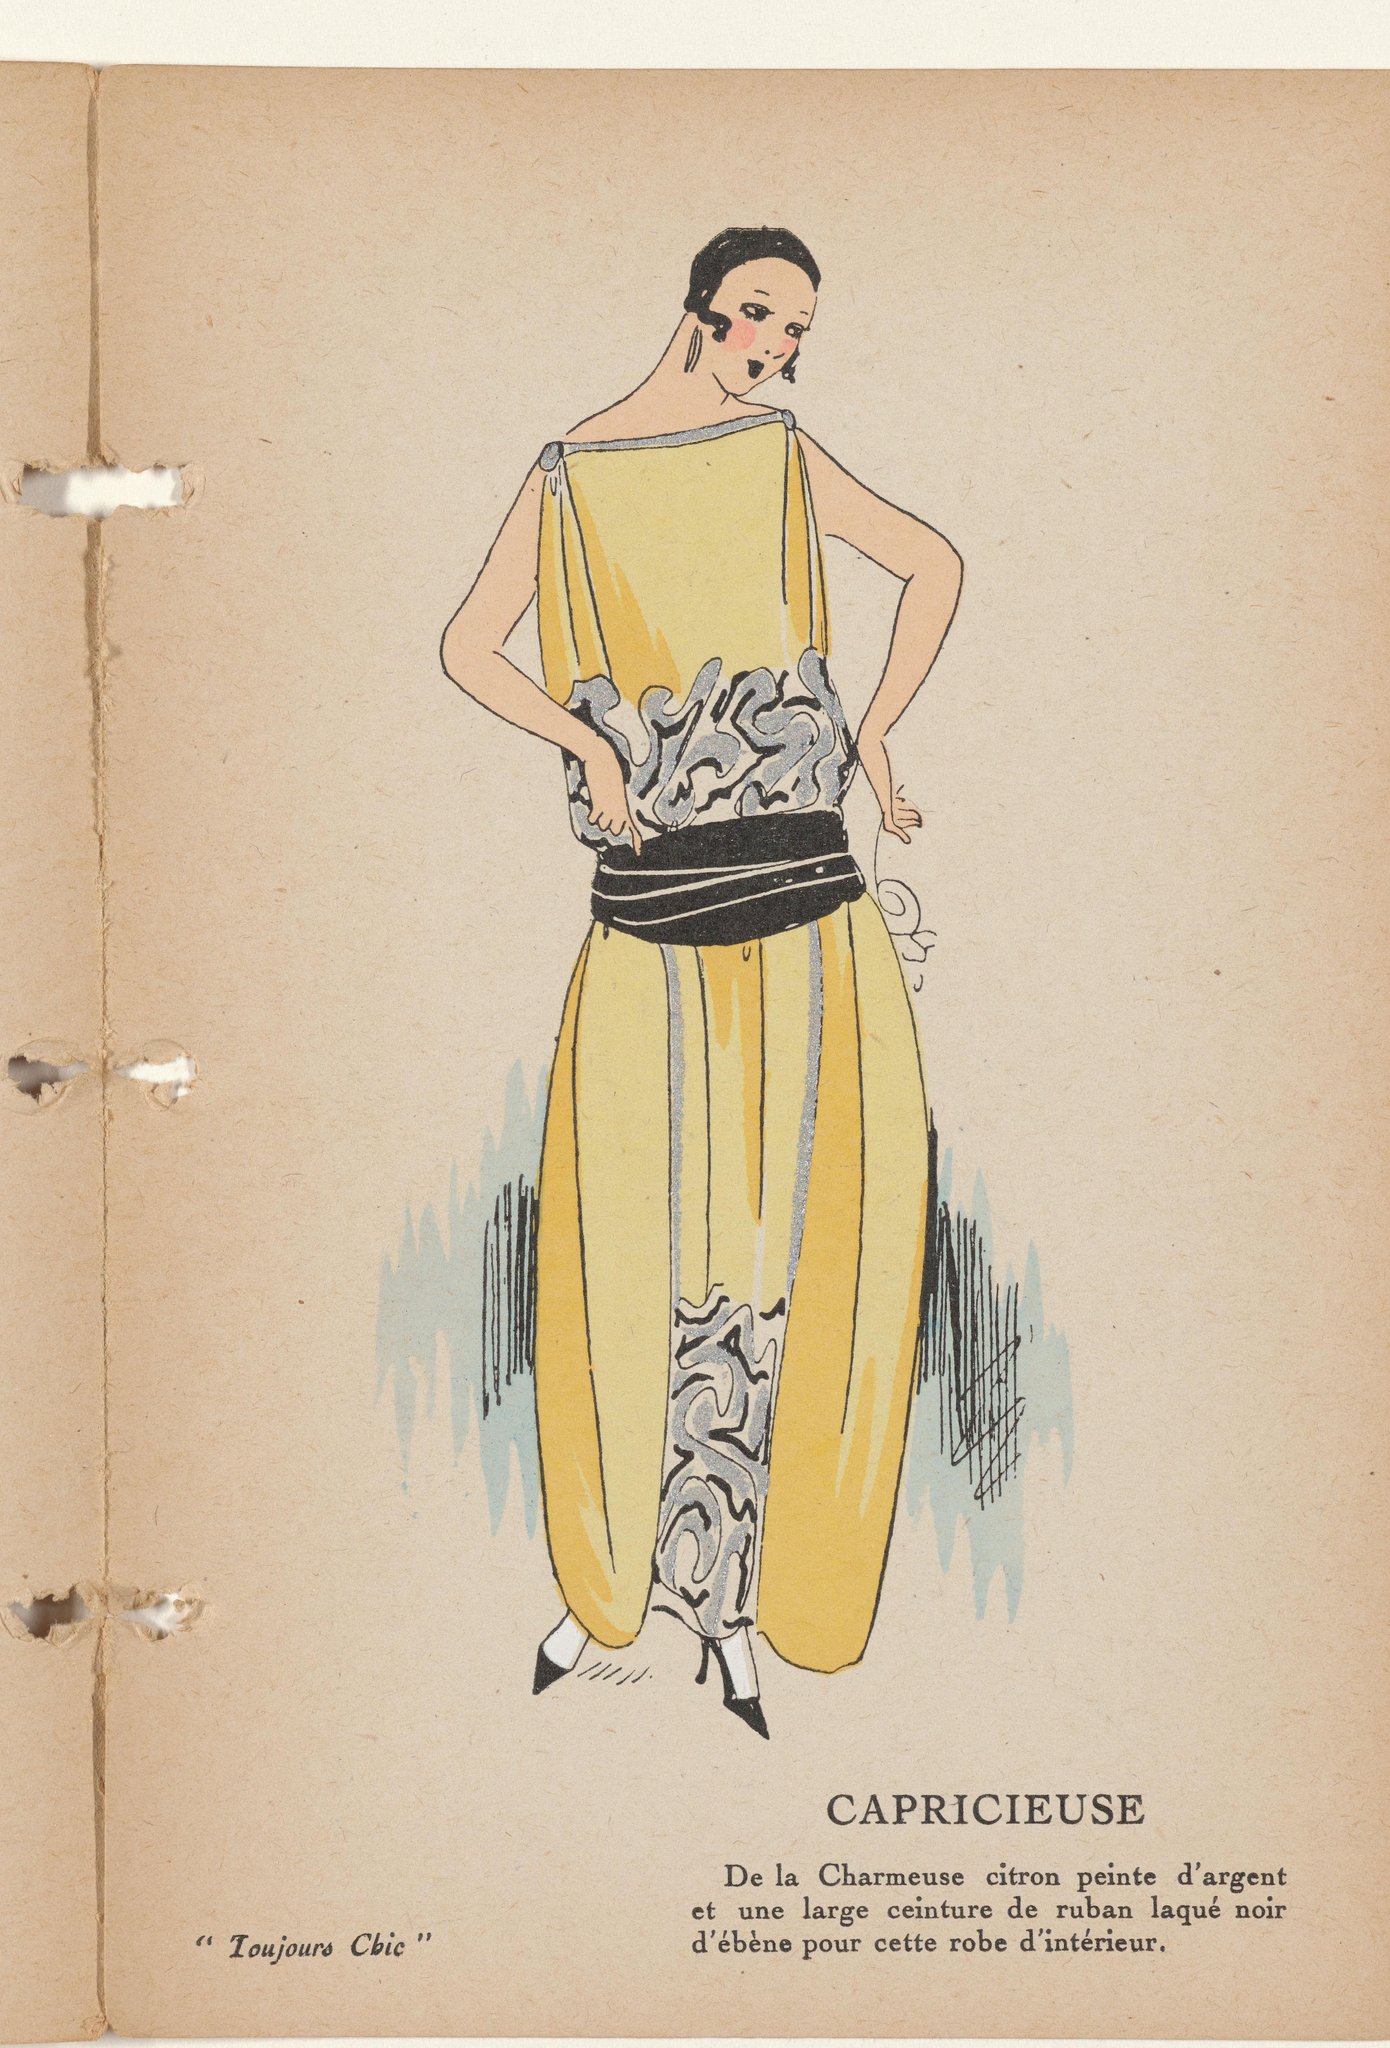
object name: fashion print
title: Toujours Chic Les Deshabillés, Hiver 1921-1922: Capricieuse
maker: g-p. joumard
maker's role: publisher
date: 1921-1922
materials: paper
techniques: letterpress printing, pochoir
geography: paris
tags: fashion plates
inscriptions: date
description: Prent uit Catalogus "Toujours Chic" waarin een overzicht van de wintermode 1921-1922.